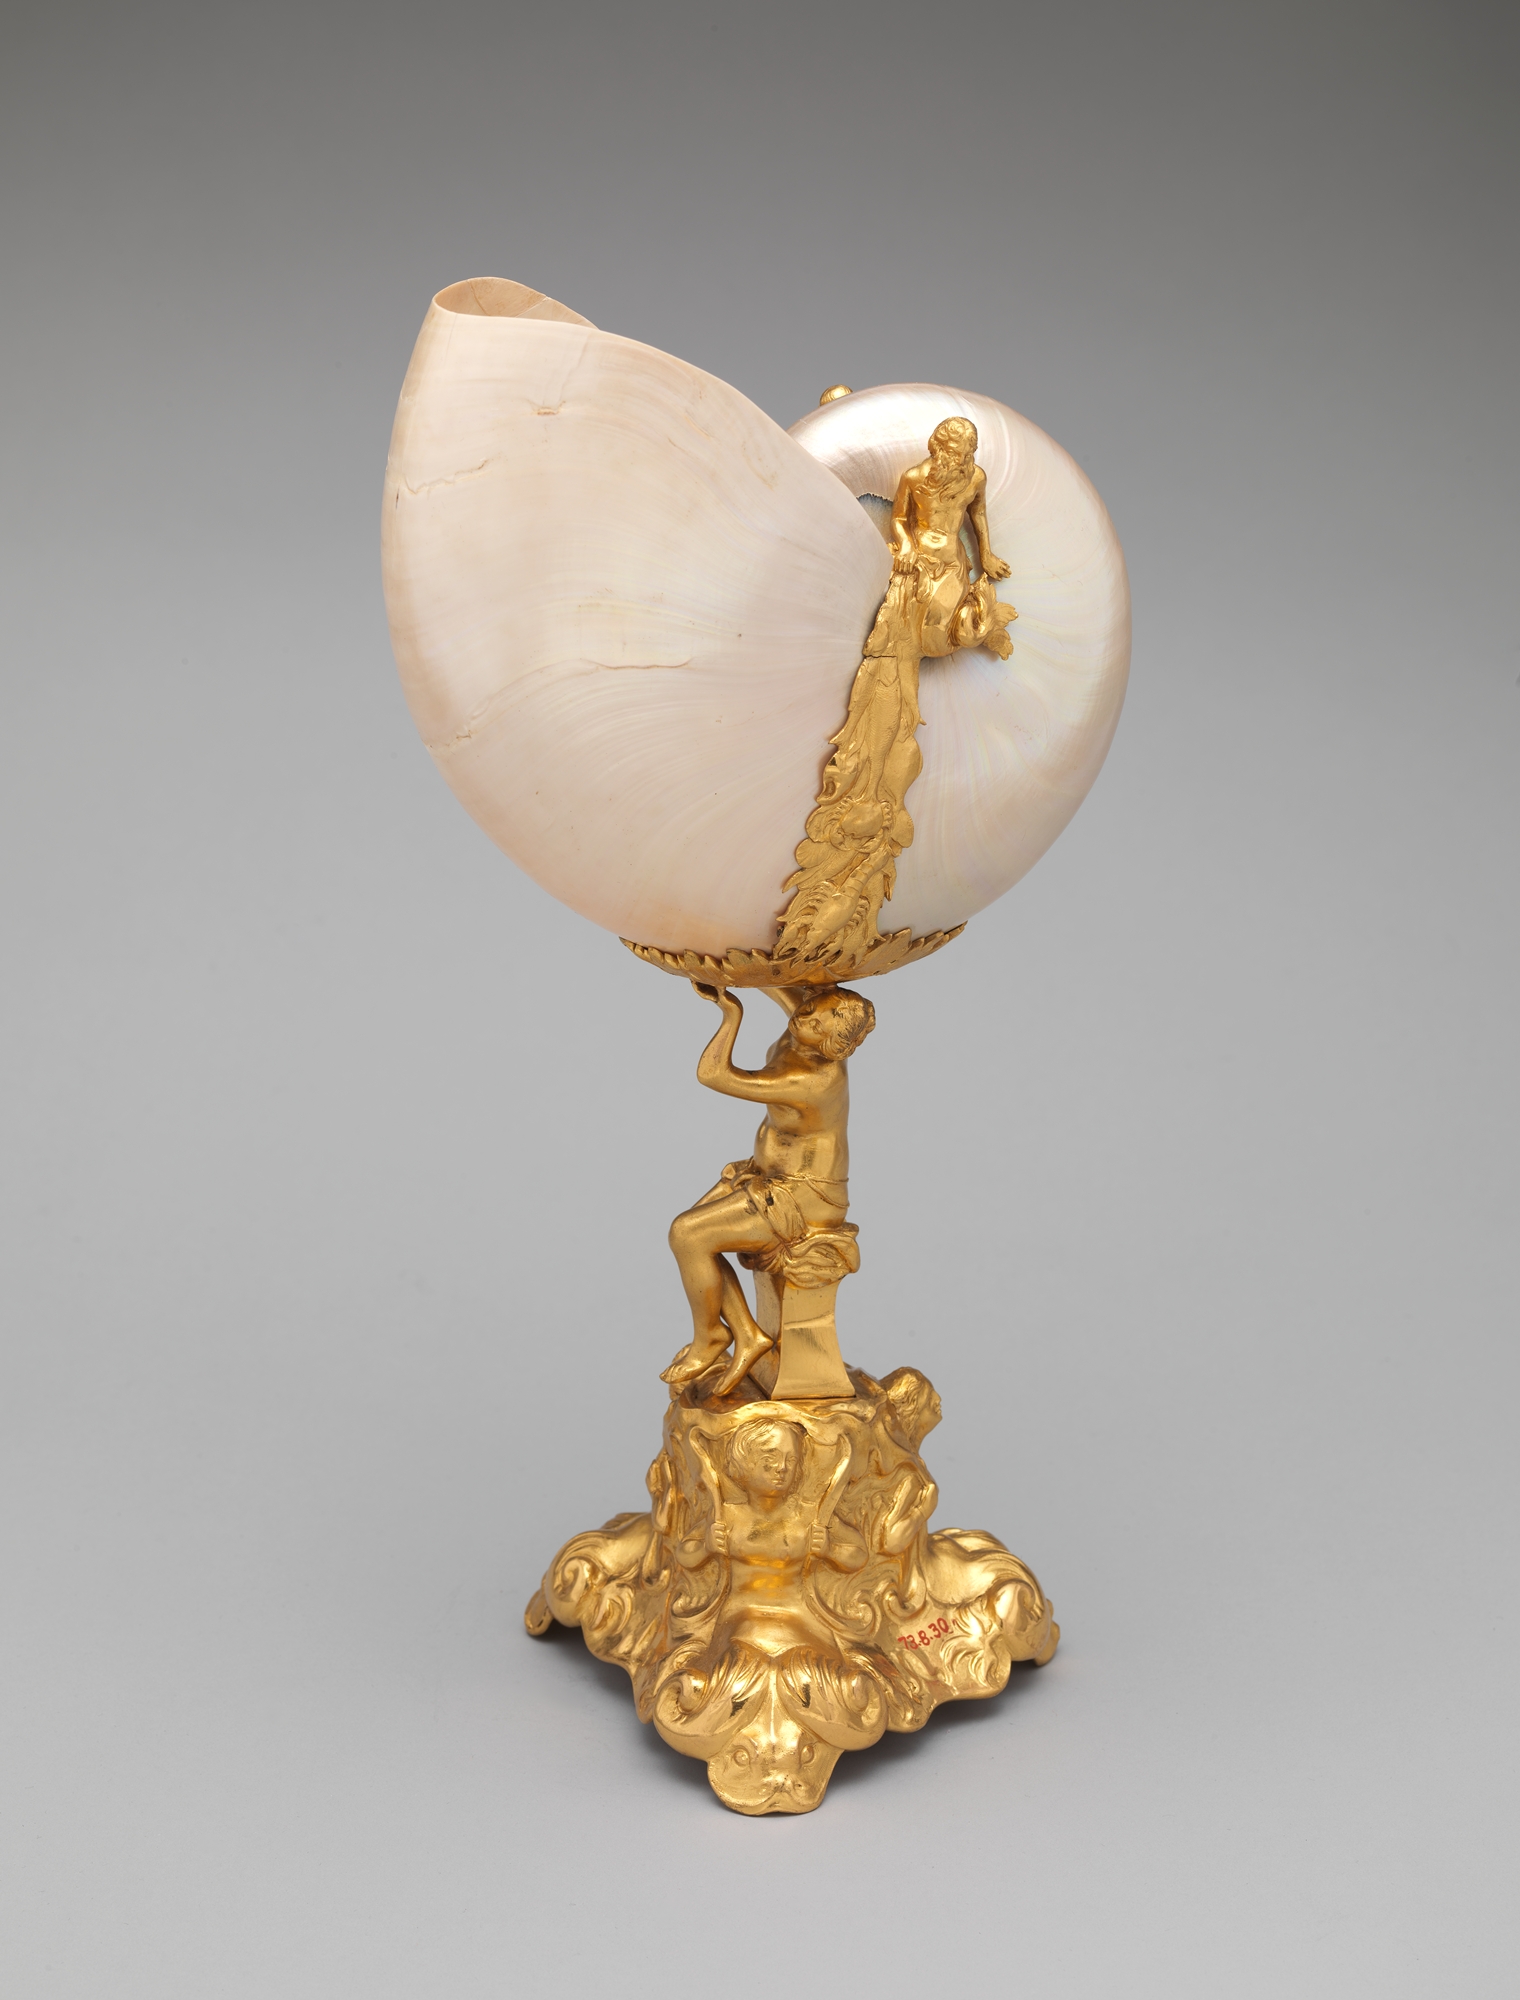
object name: nautilus shell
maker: franchi and son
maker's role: manufacturer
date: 1801-1900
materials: gilt, metal, shell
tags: men,shells